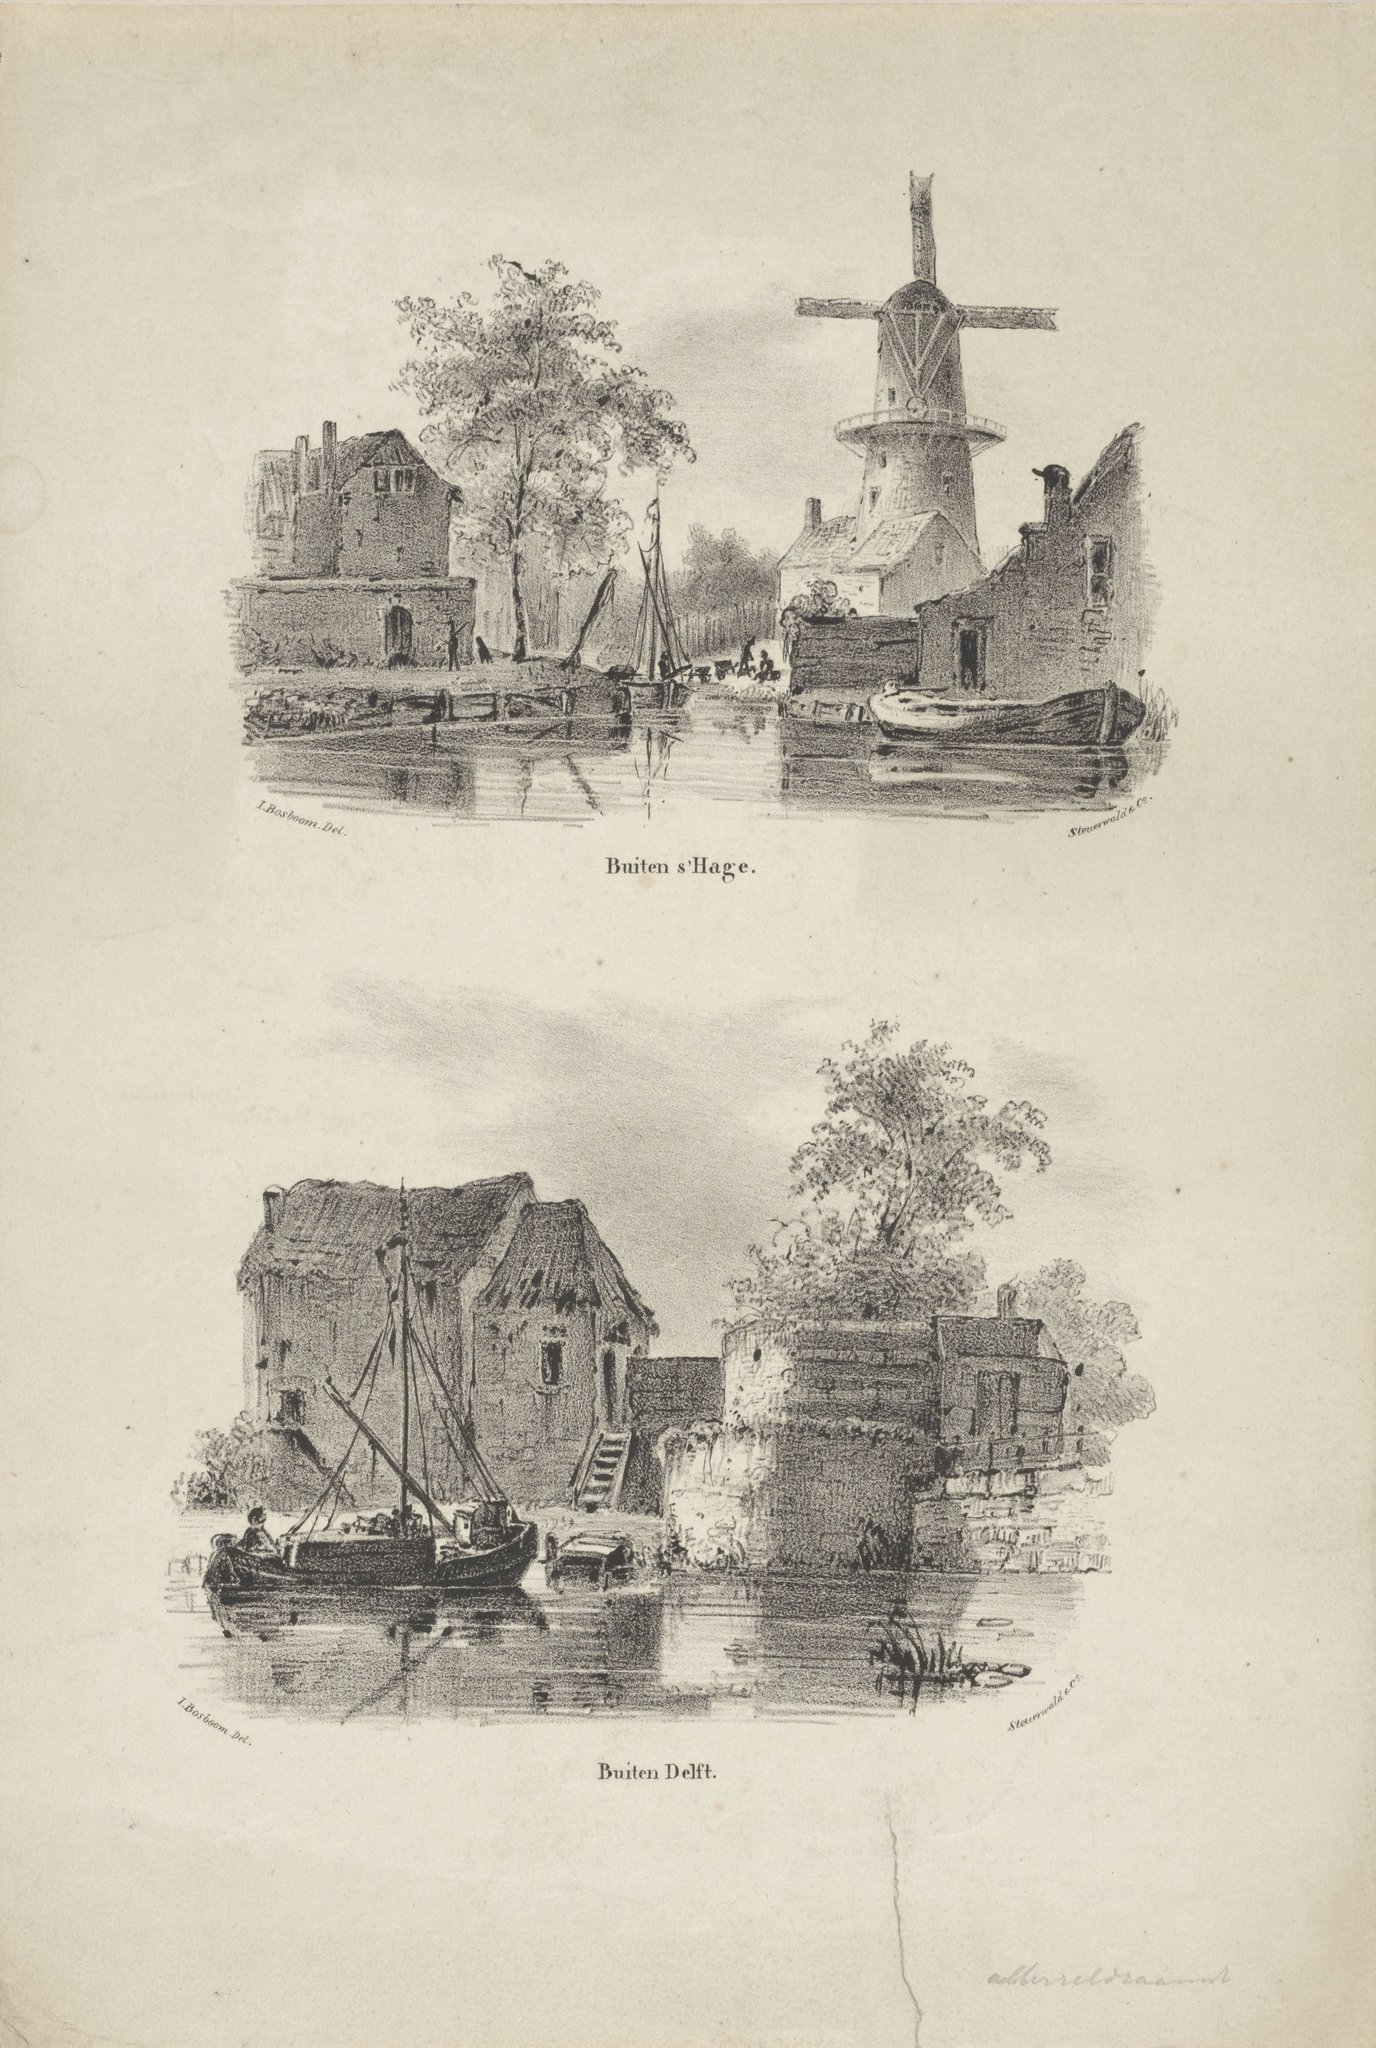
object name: print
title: Twee gezichten op Den Haag en Delft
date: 1827-1833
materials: paper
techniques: lithograph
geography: dordrecht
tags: sailing-ship, sailing-boat, city-view in general; 'veduta', windmill in landscape, the hague, delft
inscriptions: inscription: ‘allerzeldzaamst’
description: Het gezicht op Den Haag is gezien vanaf het water. Op de rechteroever van de rivier staat een molen en zijn twee figuren met karren in de weer. Op het water liggen een zeil- en roeiboot. Het gezicht op Delft laat een deel van de stadsmuur zien vanaf het water. Links komt een zeilboot met daarin een figuur aangevaren.